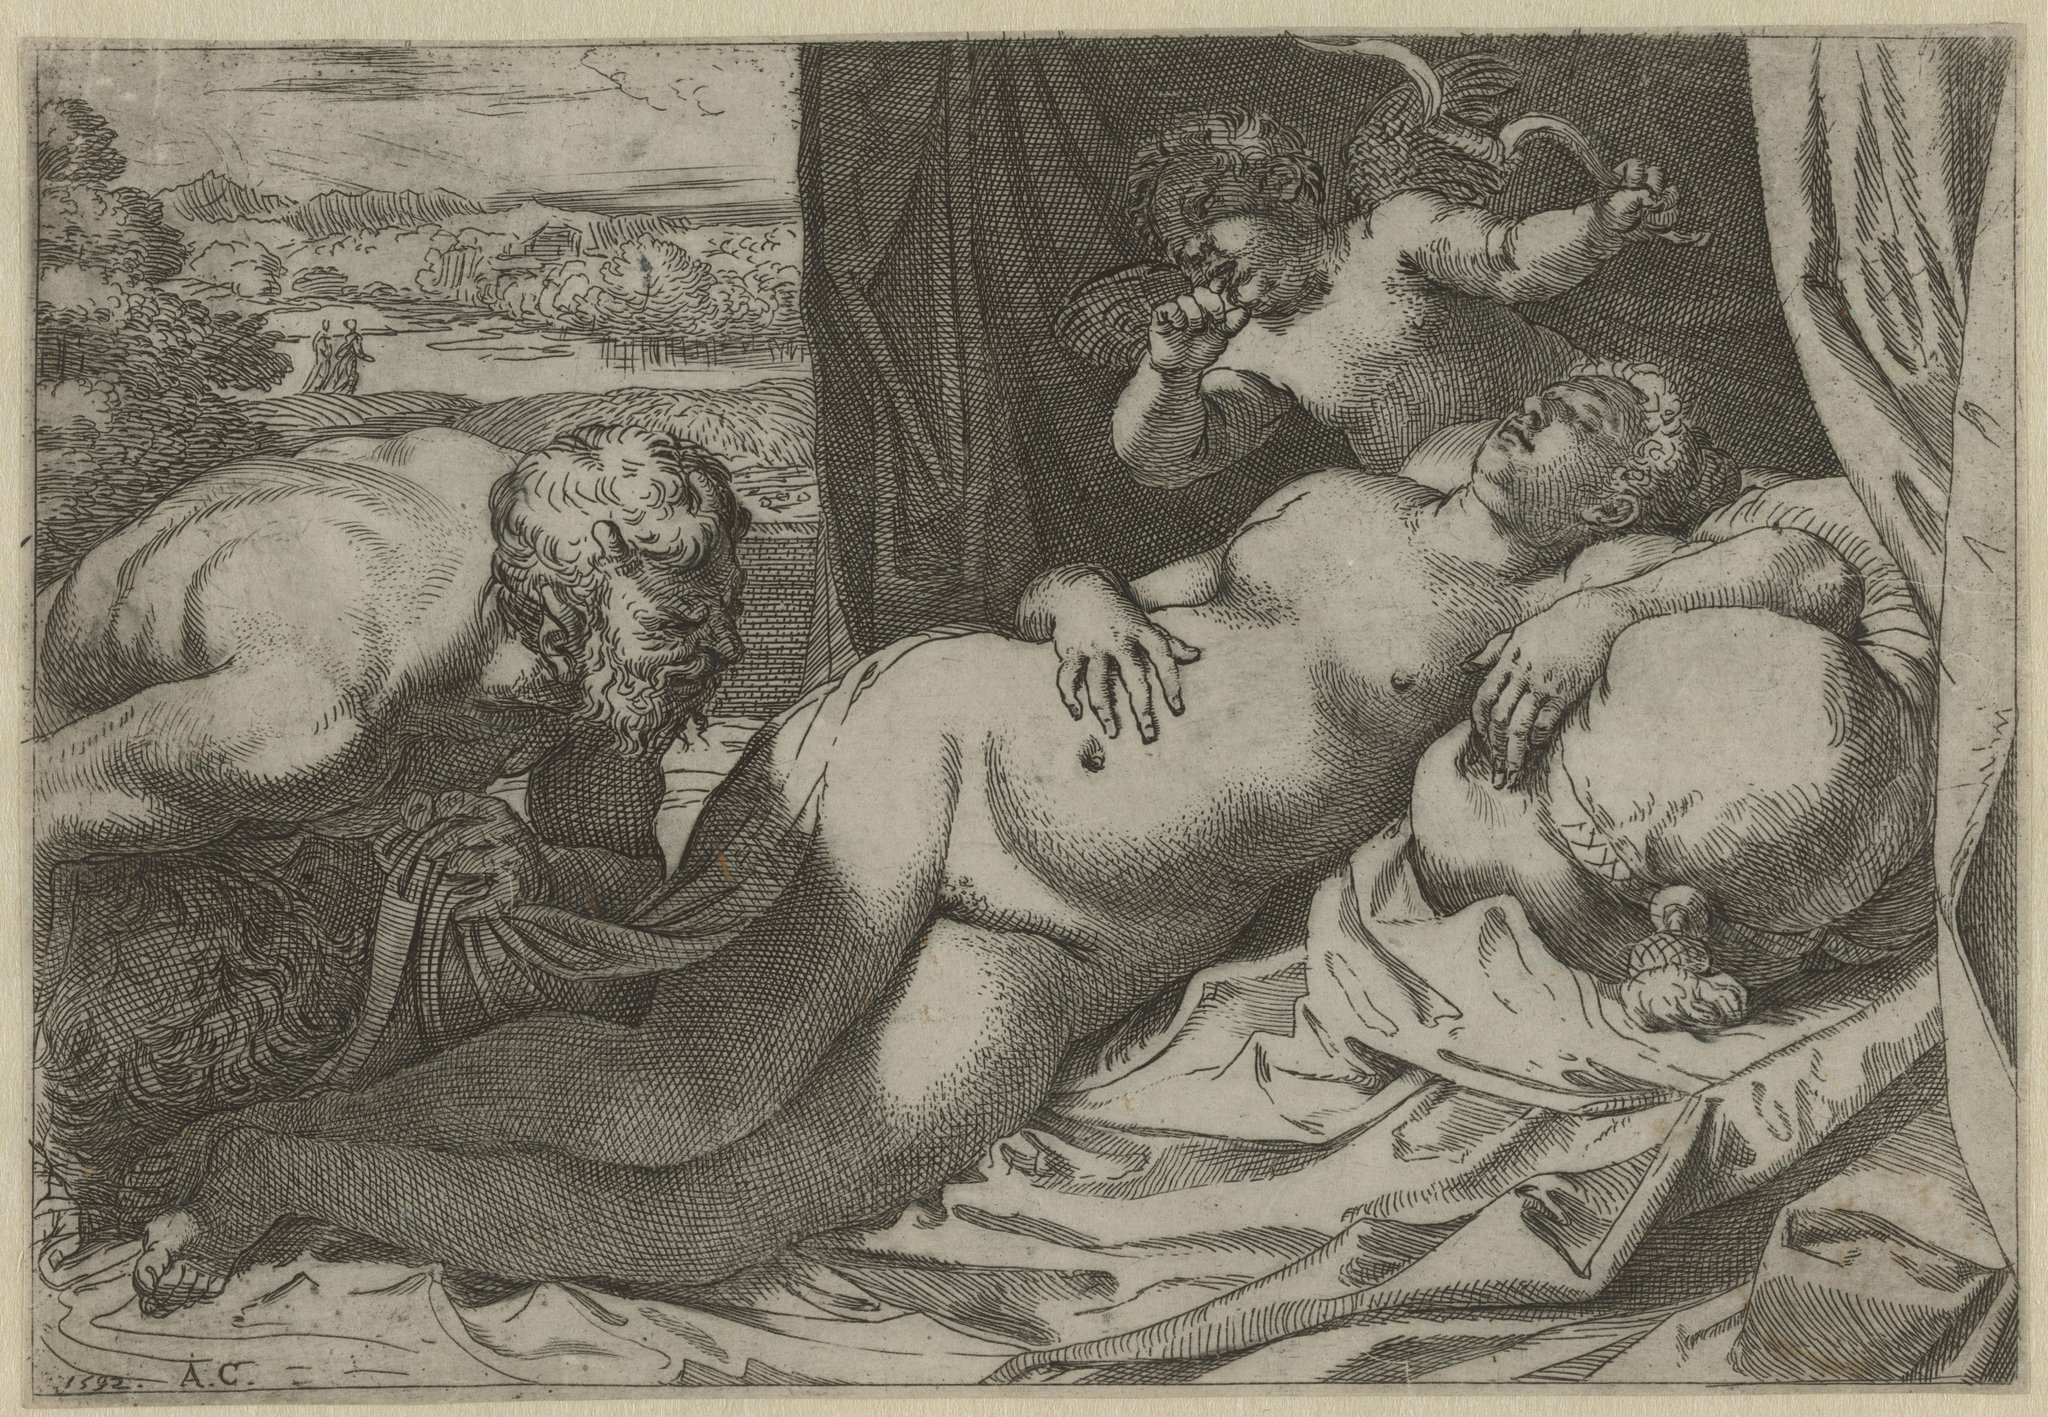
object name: print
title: Jupiter en Antiope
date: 1592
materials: paper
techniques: engraving, etching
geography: italy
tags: jupiter, disguised as a satyr, approaches the sleeping antiope; the eagle may be standing nearby, satyr(s) spying upon, (story of) venus (aphrodite), venus asleep, venus and cupid (cupid not being mere attribute)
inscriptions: collector's mark: Lugt 240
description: Een sater (mogelijk Jupiter in de gedaante van een sater) nadert de slapende Venus (mogelijk Antiope). Achter Venus staat Amor met zijn boog in zijn hand. Op de achtergrond links een landschap.